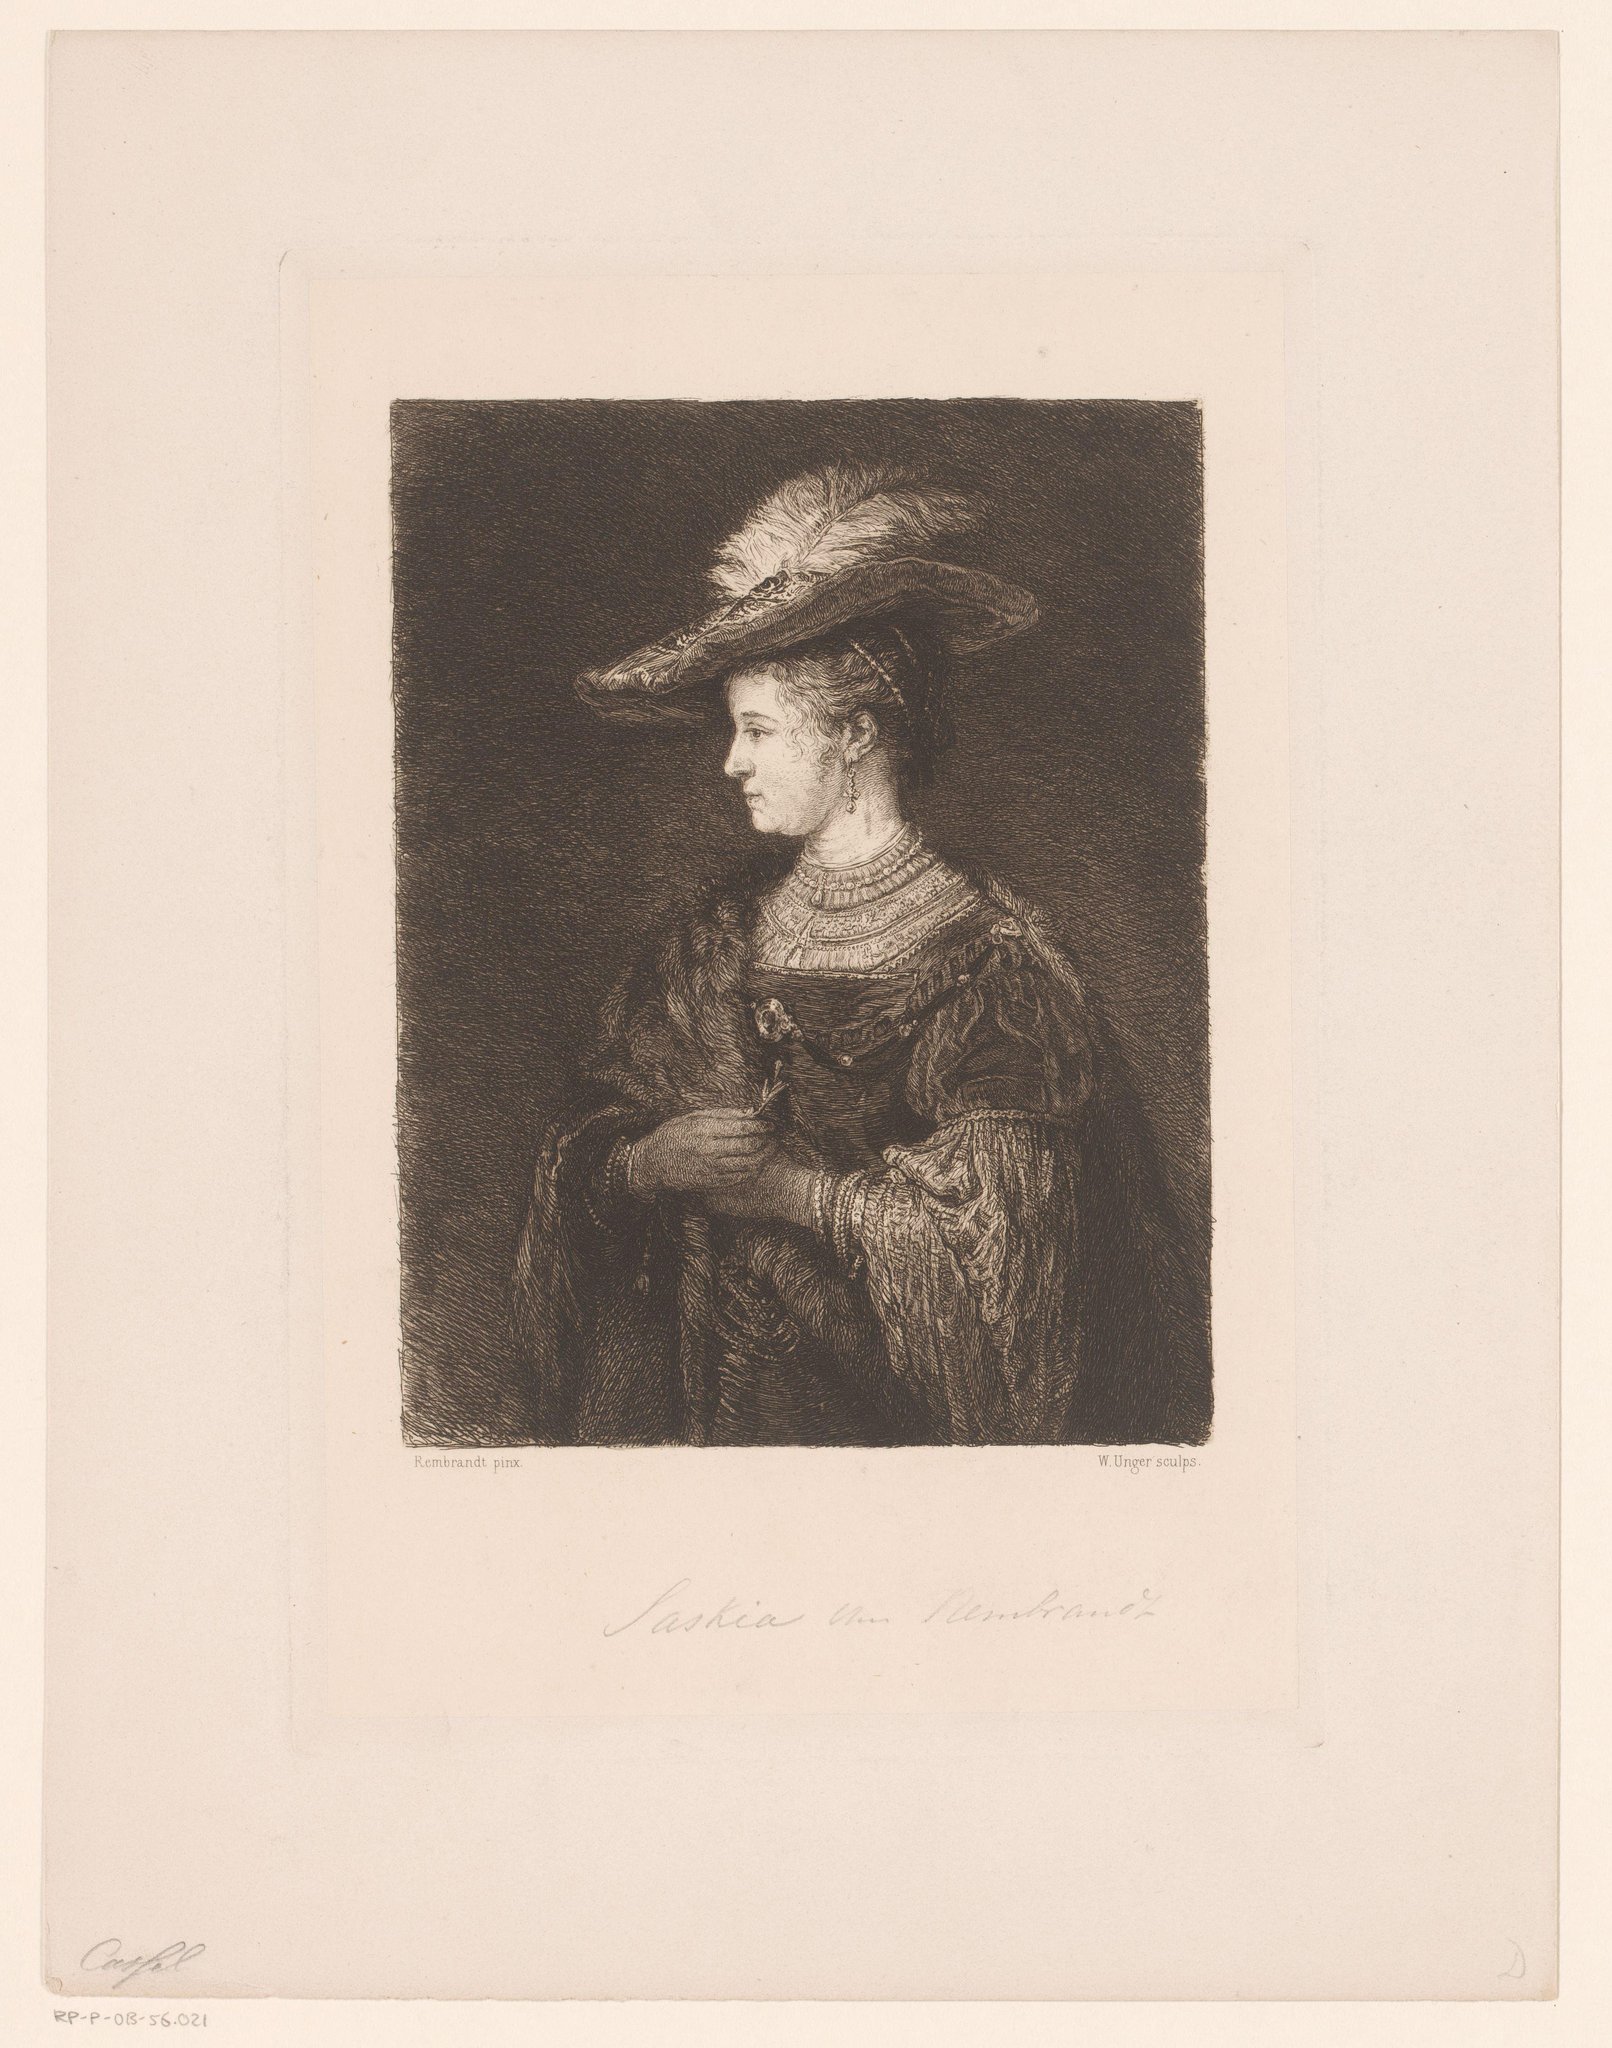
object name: print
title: Portret van Saskia van Uylenburgh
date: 1847-1889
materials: paper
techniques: etching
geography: germany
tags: amsterdam, historical persons - bb - woman, head-gear: hat, ear-rings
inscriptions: collector's mark: Lugt 2228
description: Prent naar het schilderij door Rembrandt Harmensz. van Rijn in de Gemäldegalerie Alte Meister te Kassel (inv.nr. GK 236).